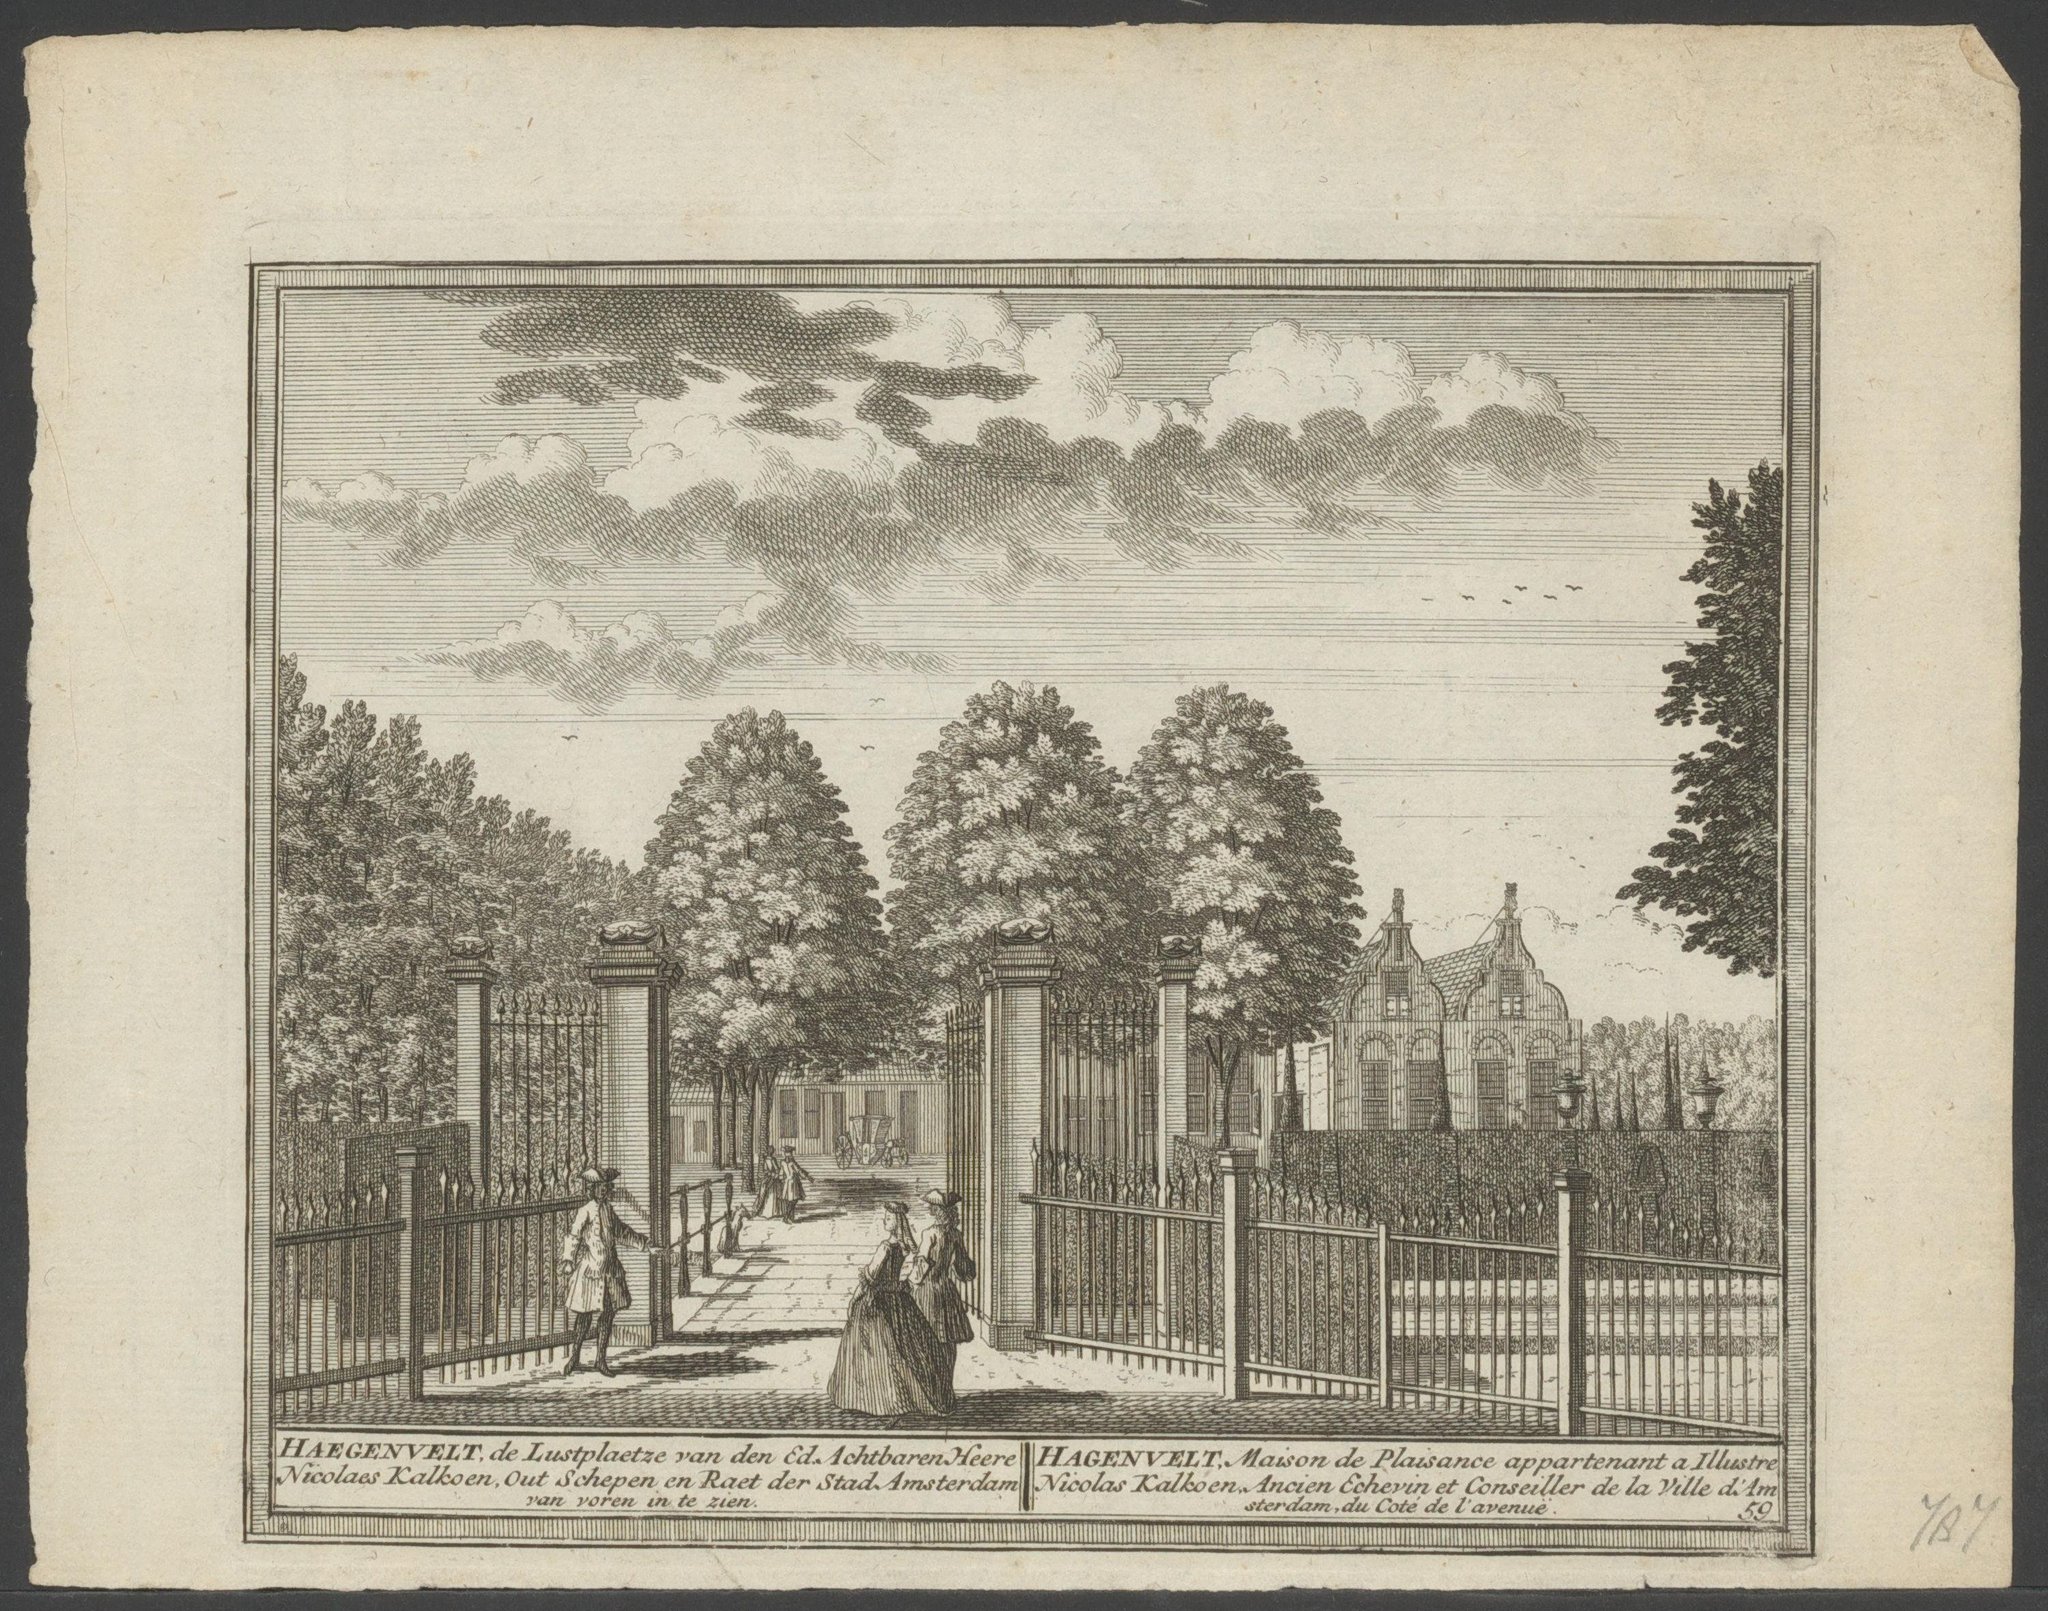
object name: print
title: Gezicht op Hofstede Hageveld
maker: hendrik de leth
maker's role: draughtsman, print maker, publisher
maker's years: 1703-1766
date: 1729-1732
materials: paper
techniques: engraving, etching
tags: rural housing, e.g. country-house, villa, cottage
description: Prent mogelijk uit: Nidek, Matthaeus Brouërius. Het zegenpralent Kennemerlant, vertoont in veele heerelyke gezichten van deszelfs voornaemste lustplaetzen, adelyke huizen, dorp- en stede-gebouwen (...). Amsterdam: Andries en Hendrik de Leth, 1729-1732.